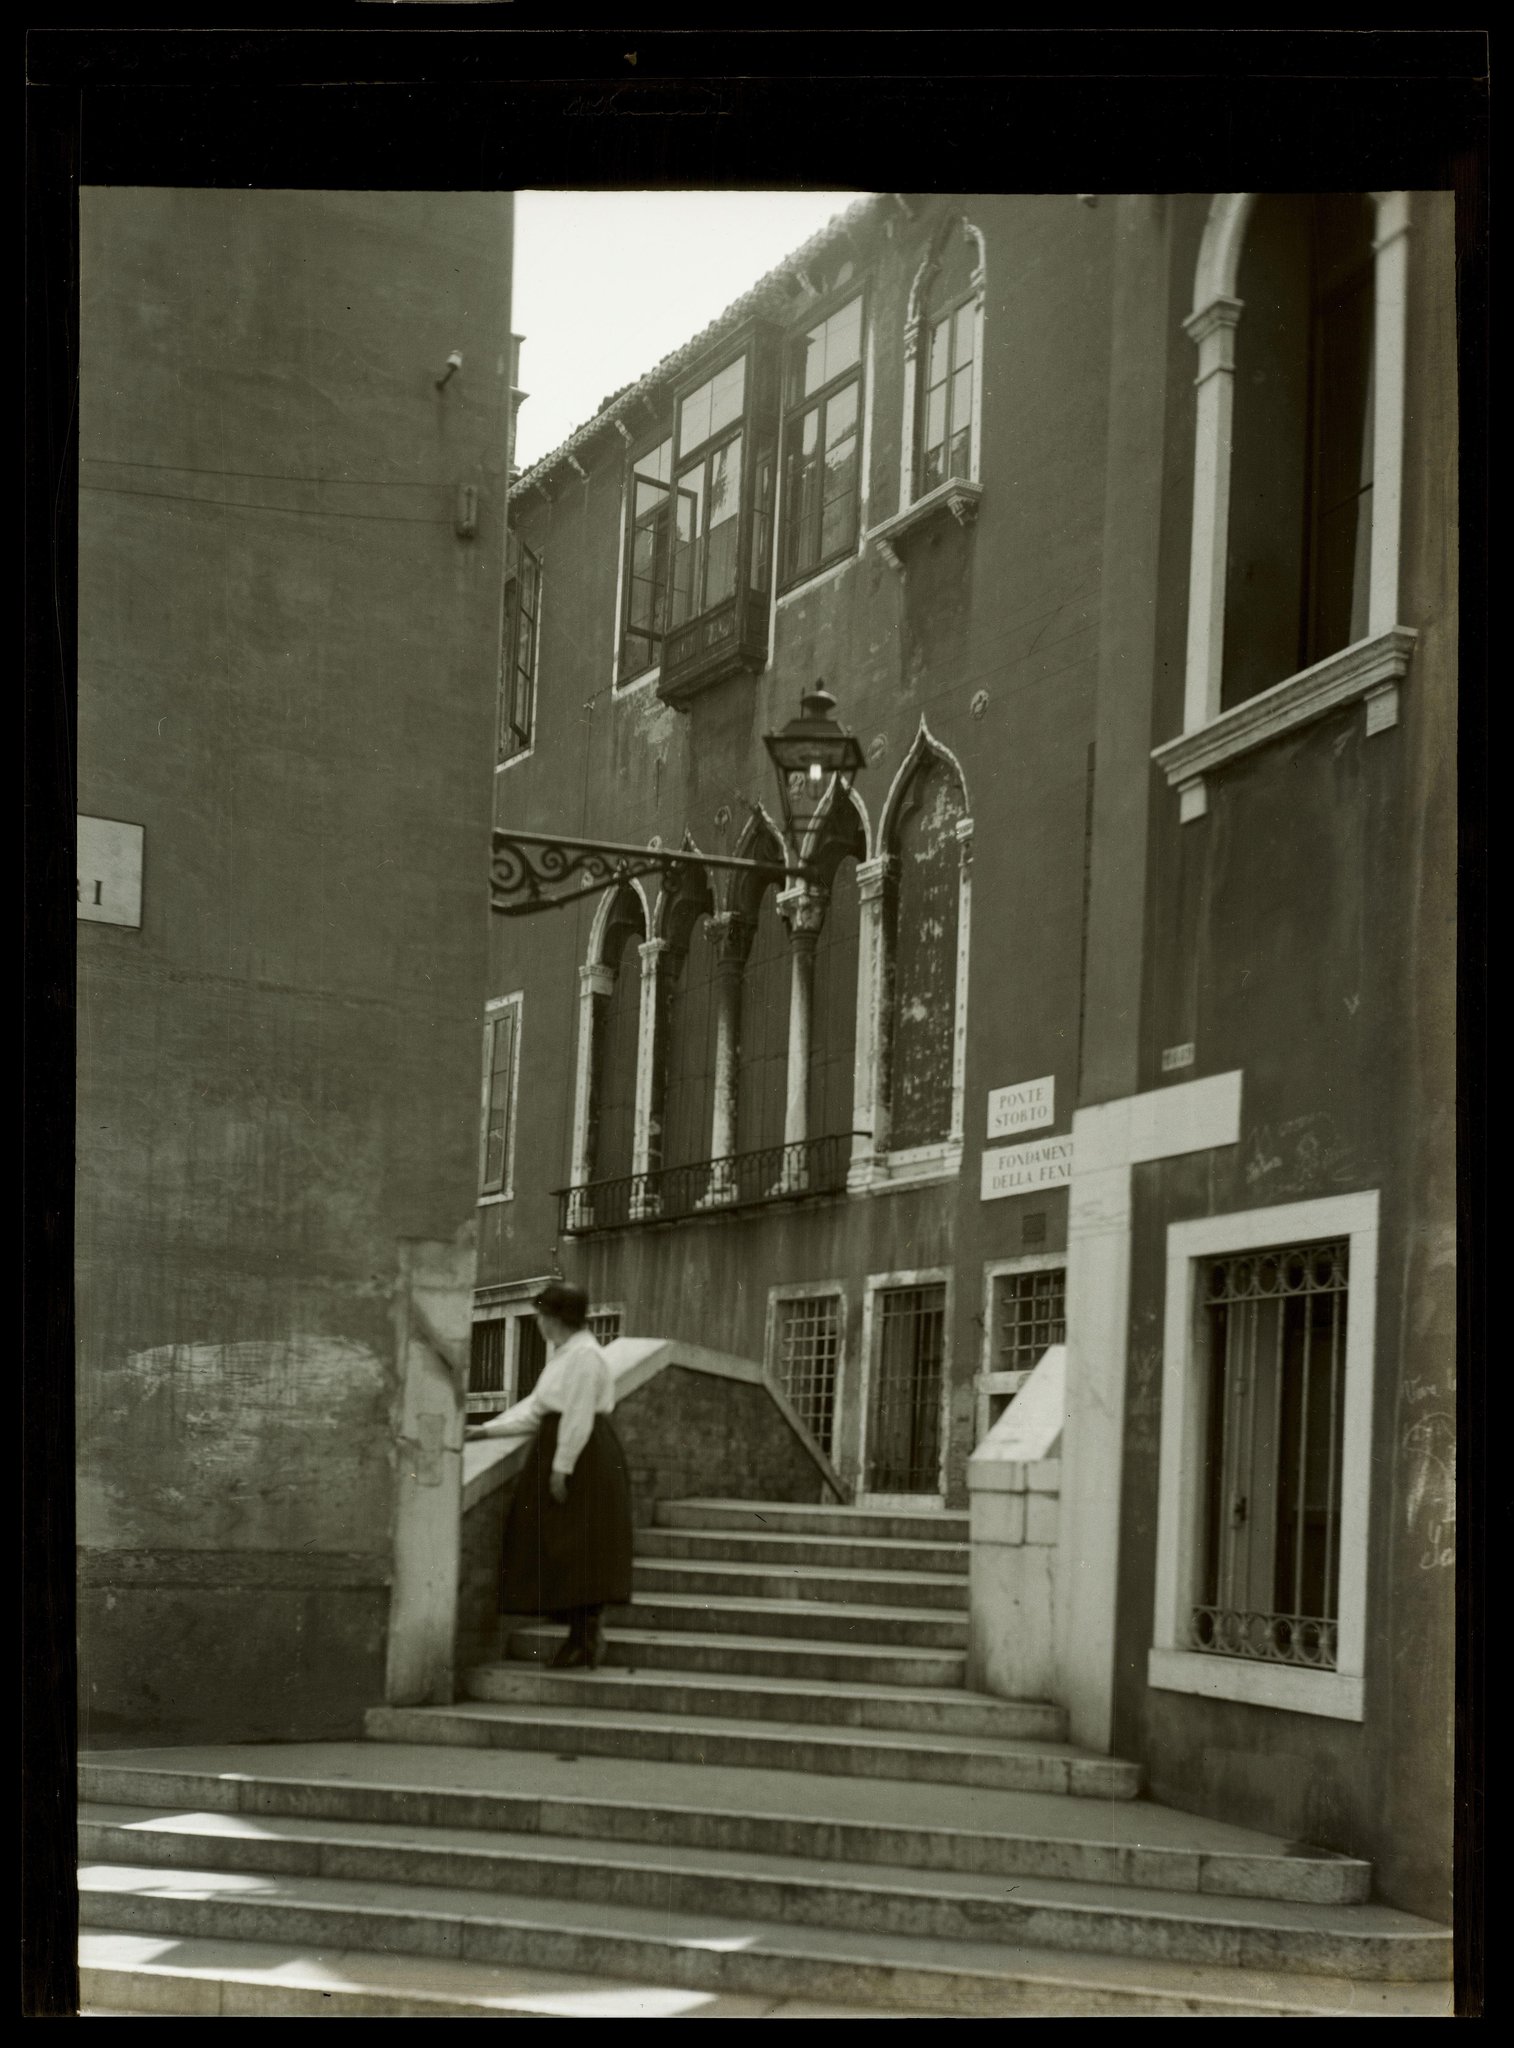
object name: negative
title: Filmnegatief met opname van Venetië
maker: Anonymous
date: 1907-1935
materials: film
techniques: gelatin silver negative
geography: venice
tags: venice